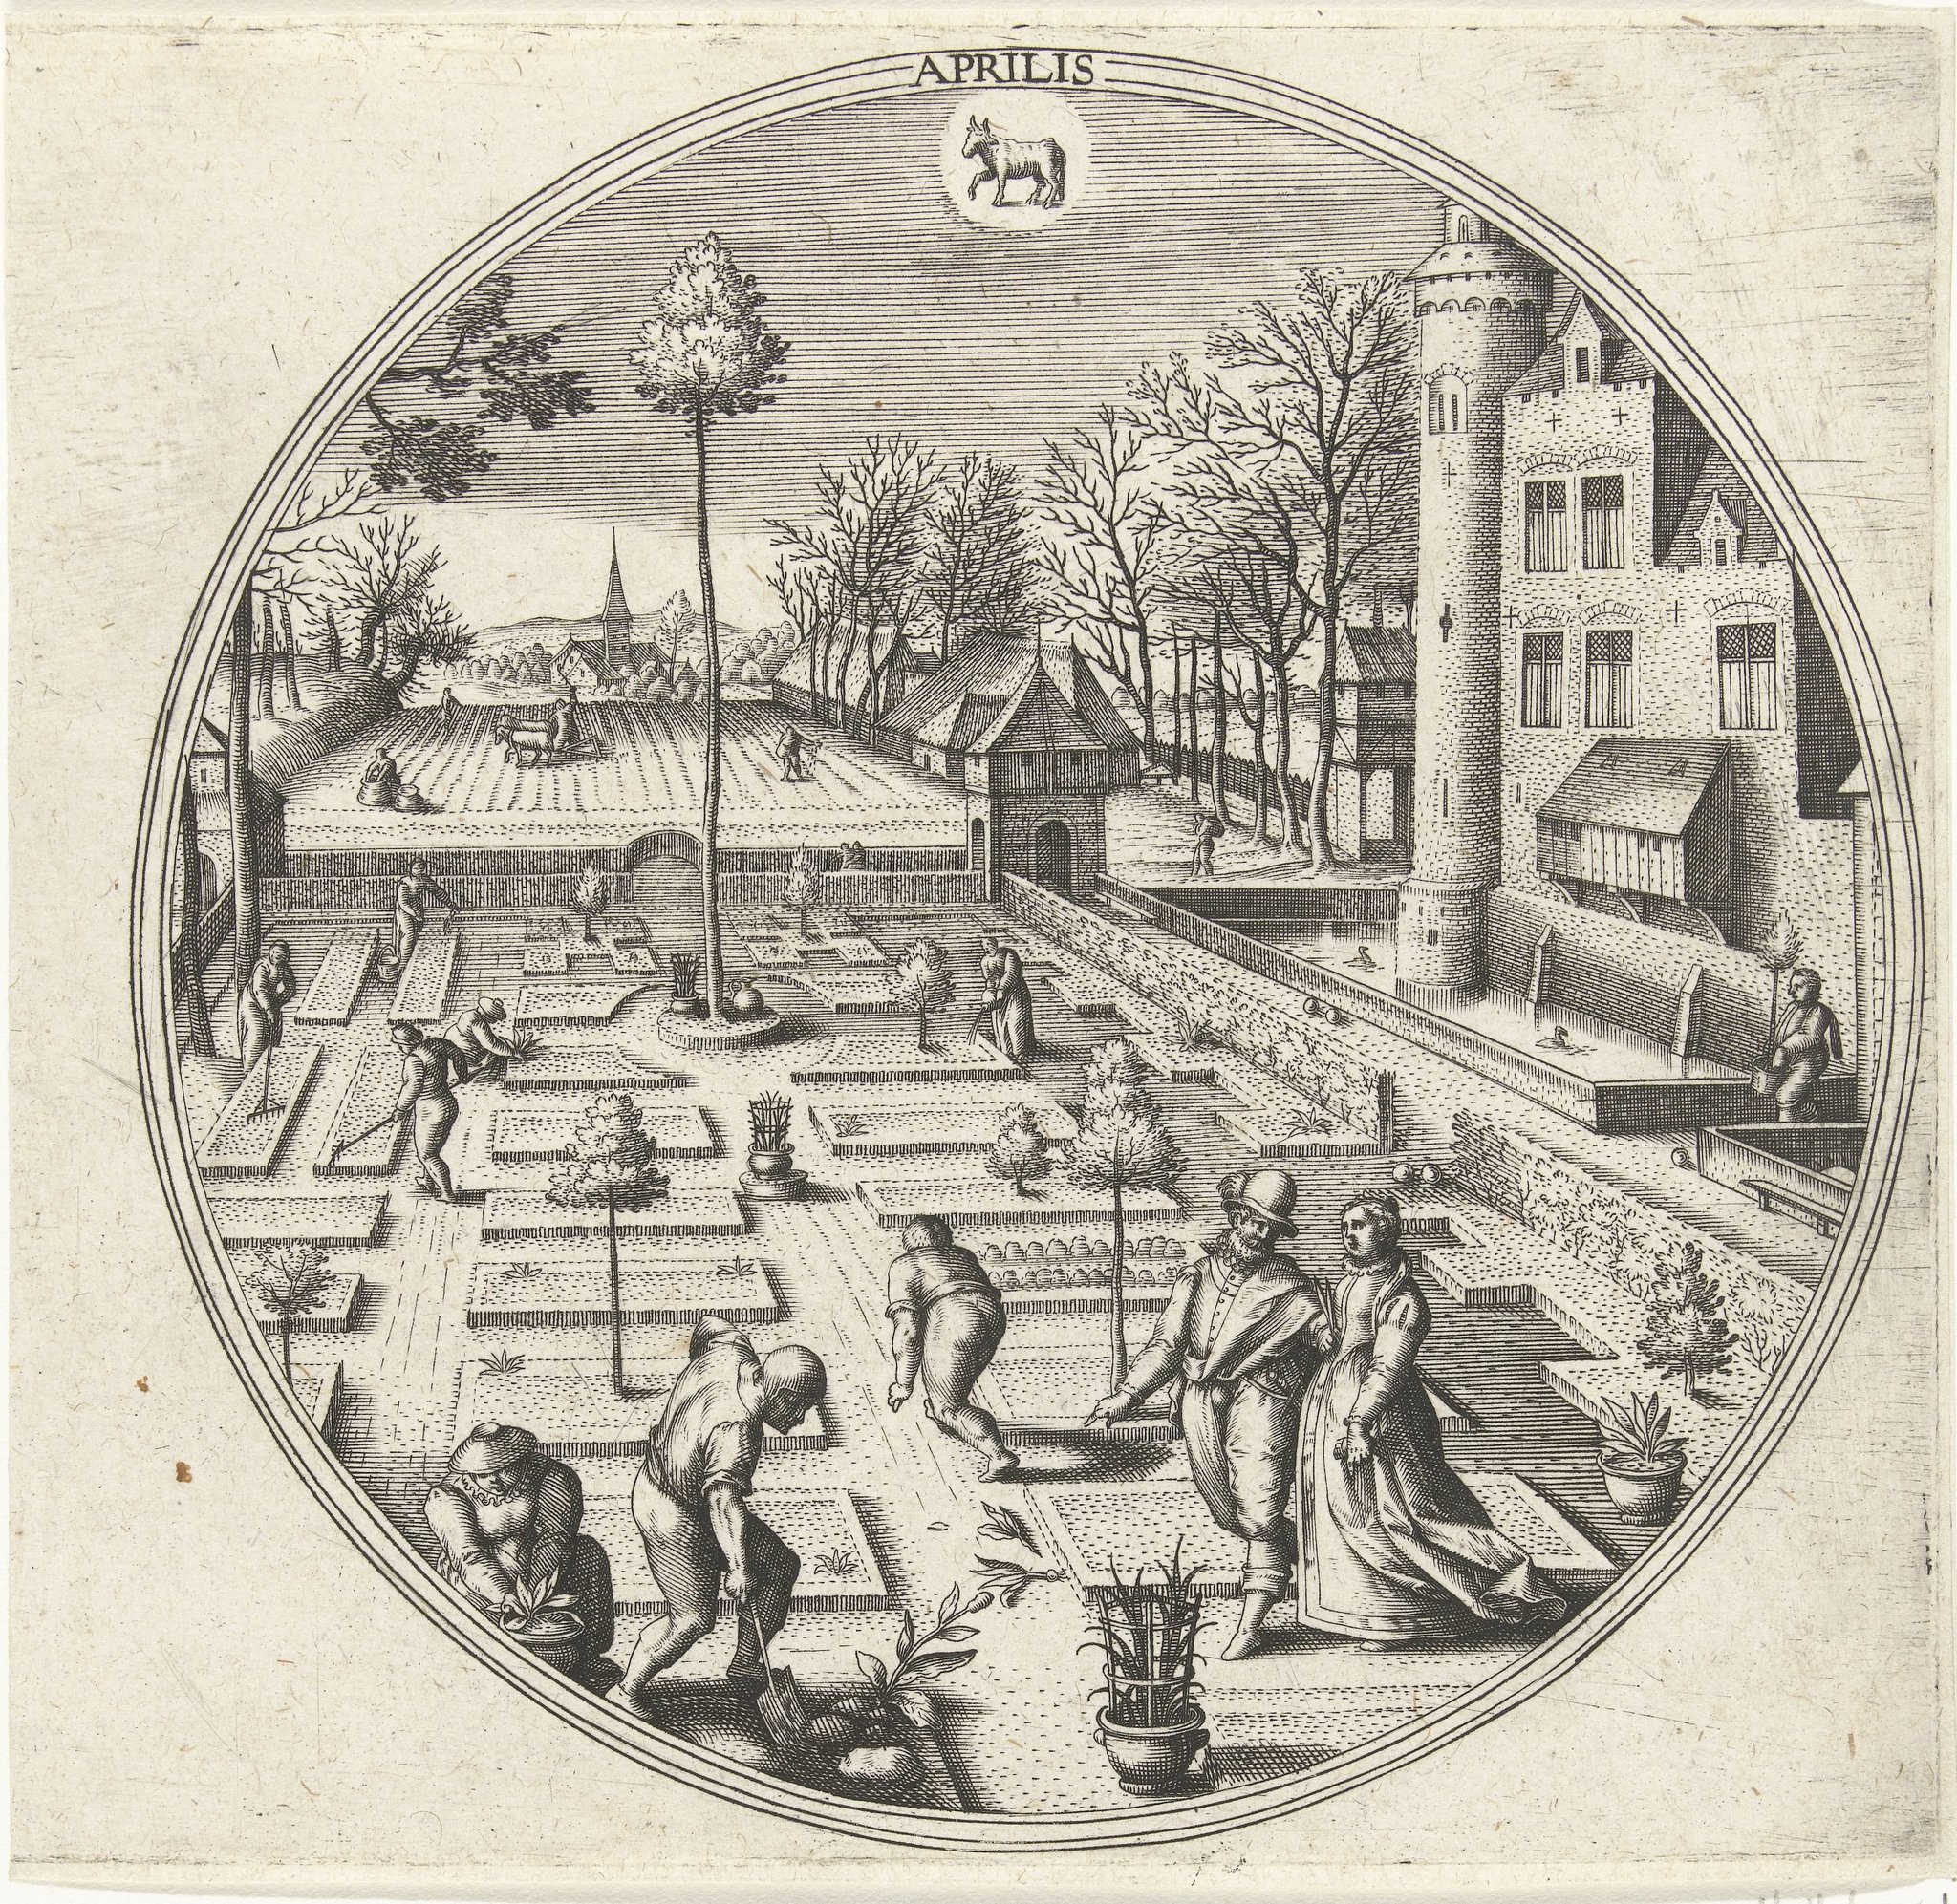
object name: print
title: April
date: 1578-1582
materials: paper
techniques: engraving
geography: antwerp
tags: sowing, april and its 'labours' (+ with zodiacal signs), ploughing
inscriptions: collector's mark: Lugt 2228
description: Ronde lijst met een lentelandschap met voorjaarstaferelen. April is de grasmaand. Op de voorgrond wordt gespit en gezaaid in de tuin. Op de achtergrond wordt een veld omgeploegd. Middenboven het sterrenbeeld Stier. De prent is deel van een twaalfdelige serie over de twaalf maanden.